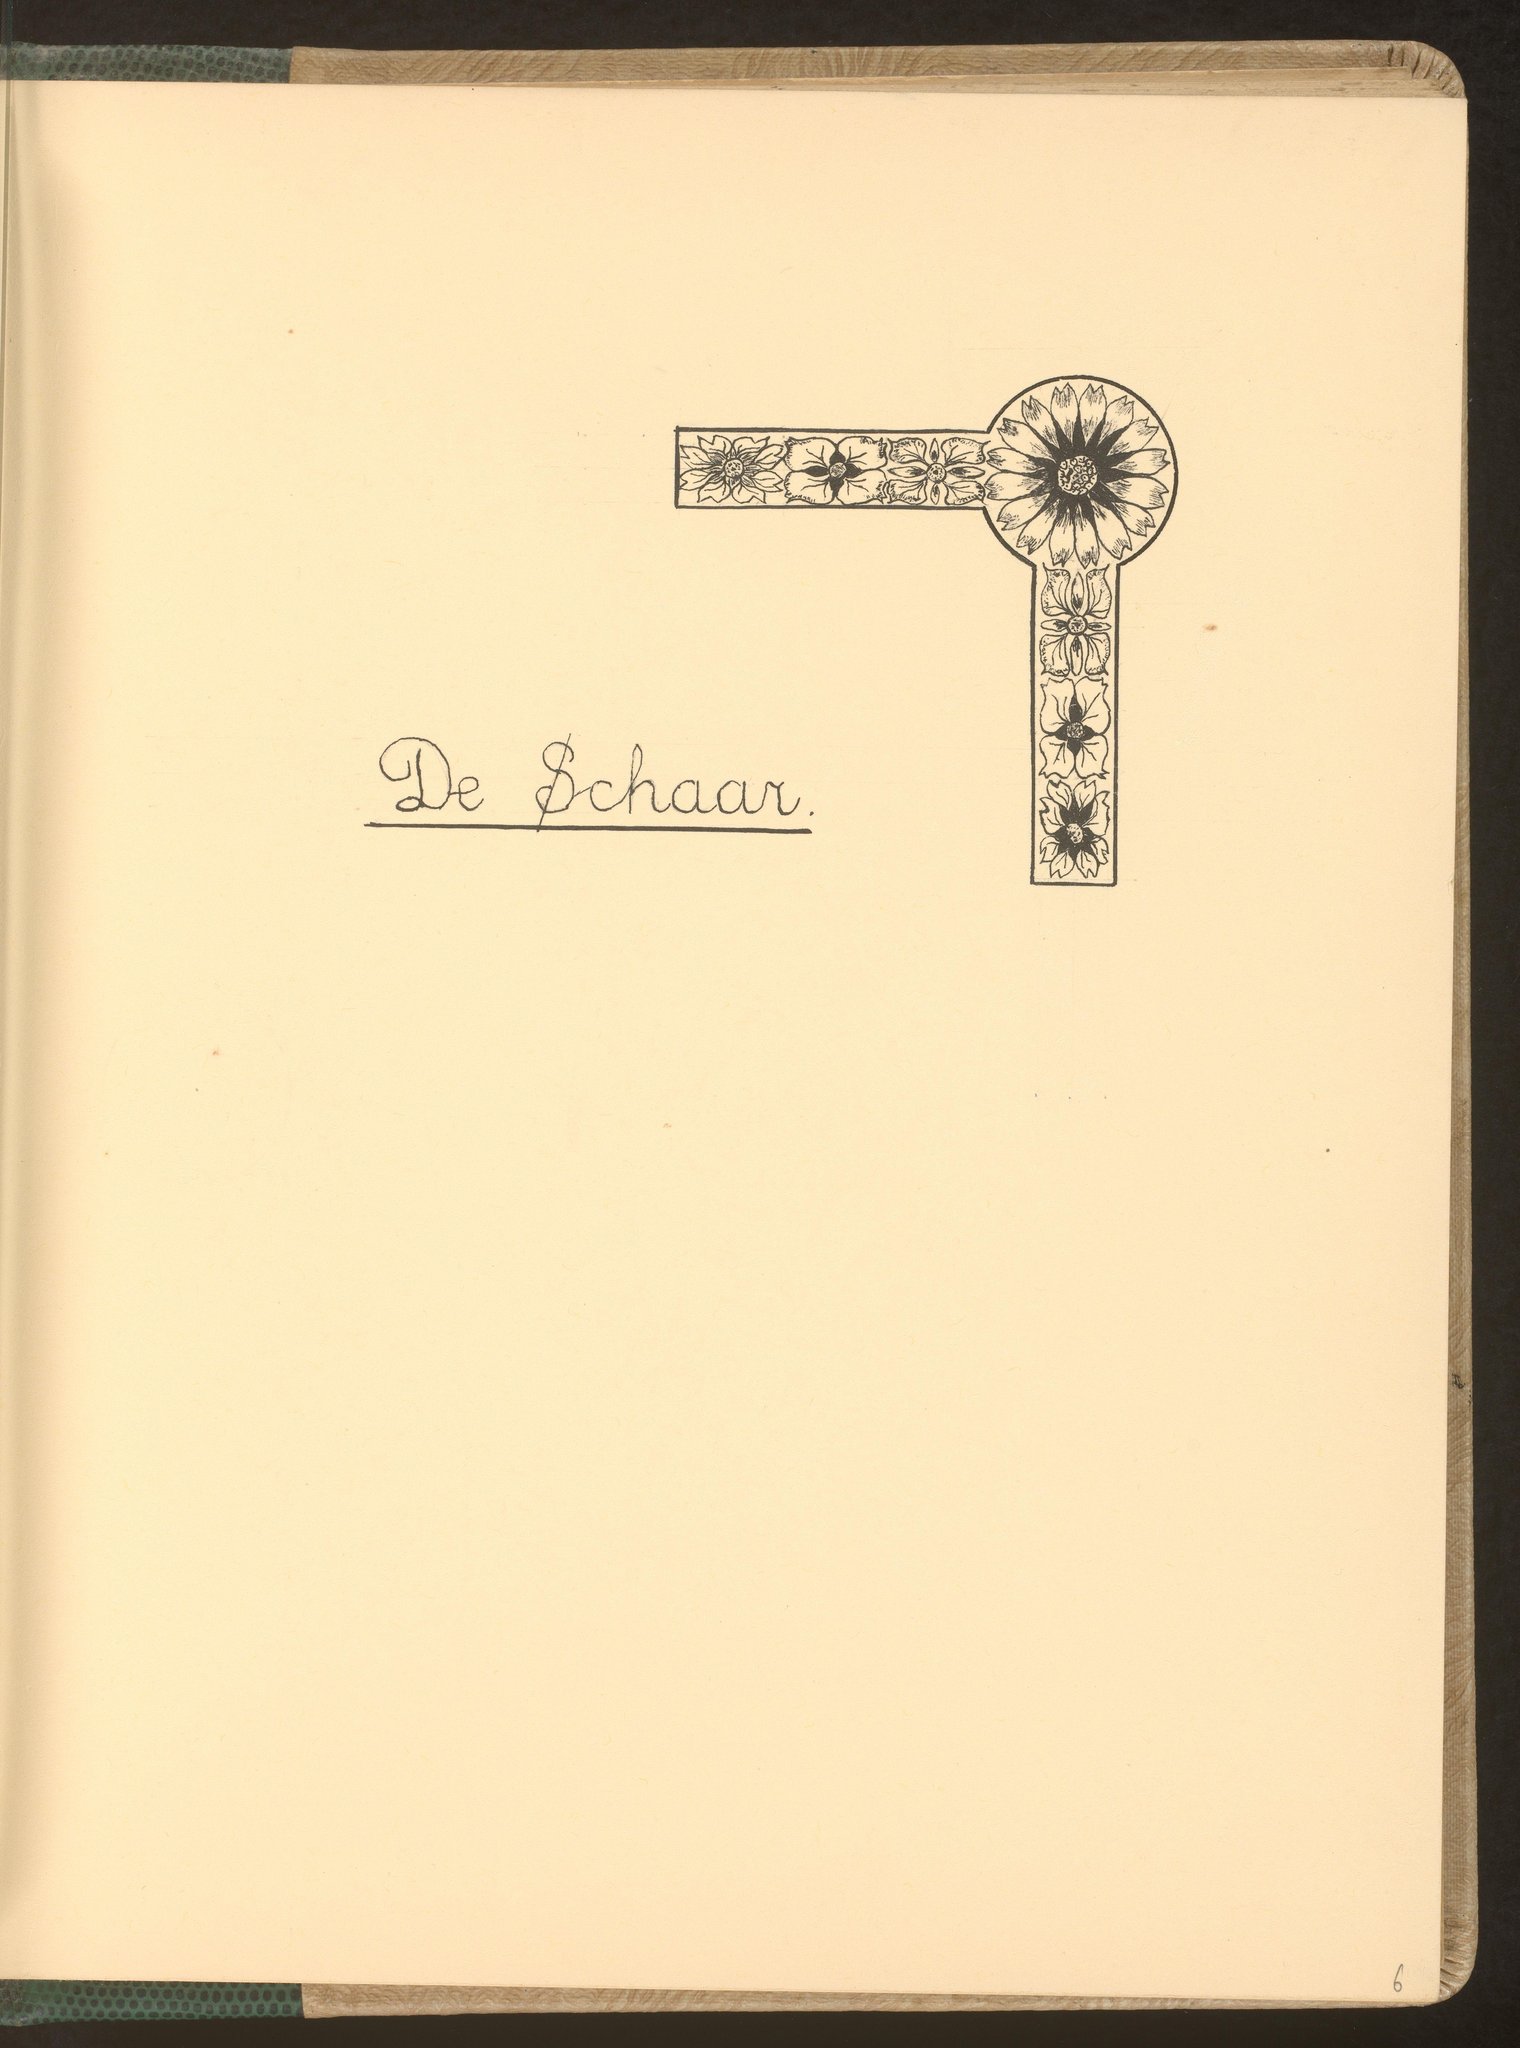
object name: manuscript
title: De Schaar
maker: Anonymous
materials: ink, paper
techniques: handwriting, pen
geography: lochem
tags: amsterdam, the hague, willem drees, old-people's home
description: Handgeschreven titel voor de foto op het volgende blad. Onderdeel van het fotoalbum over de opening van het bejaardenhuis De Berkelhof in Lochem door premier Willem Drees op 8 augustus 1953.